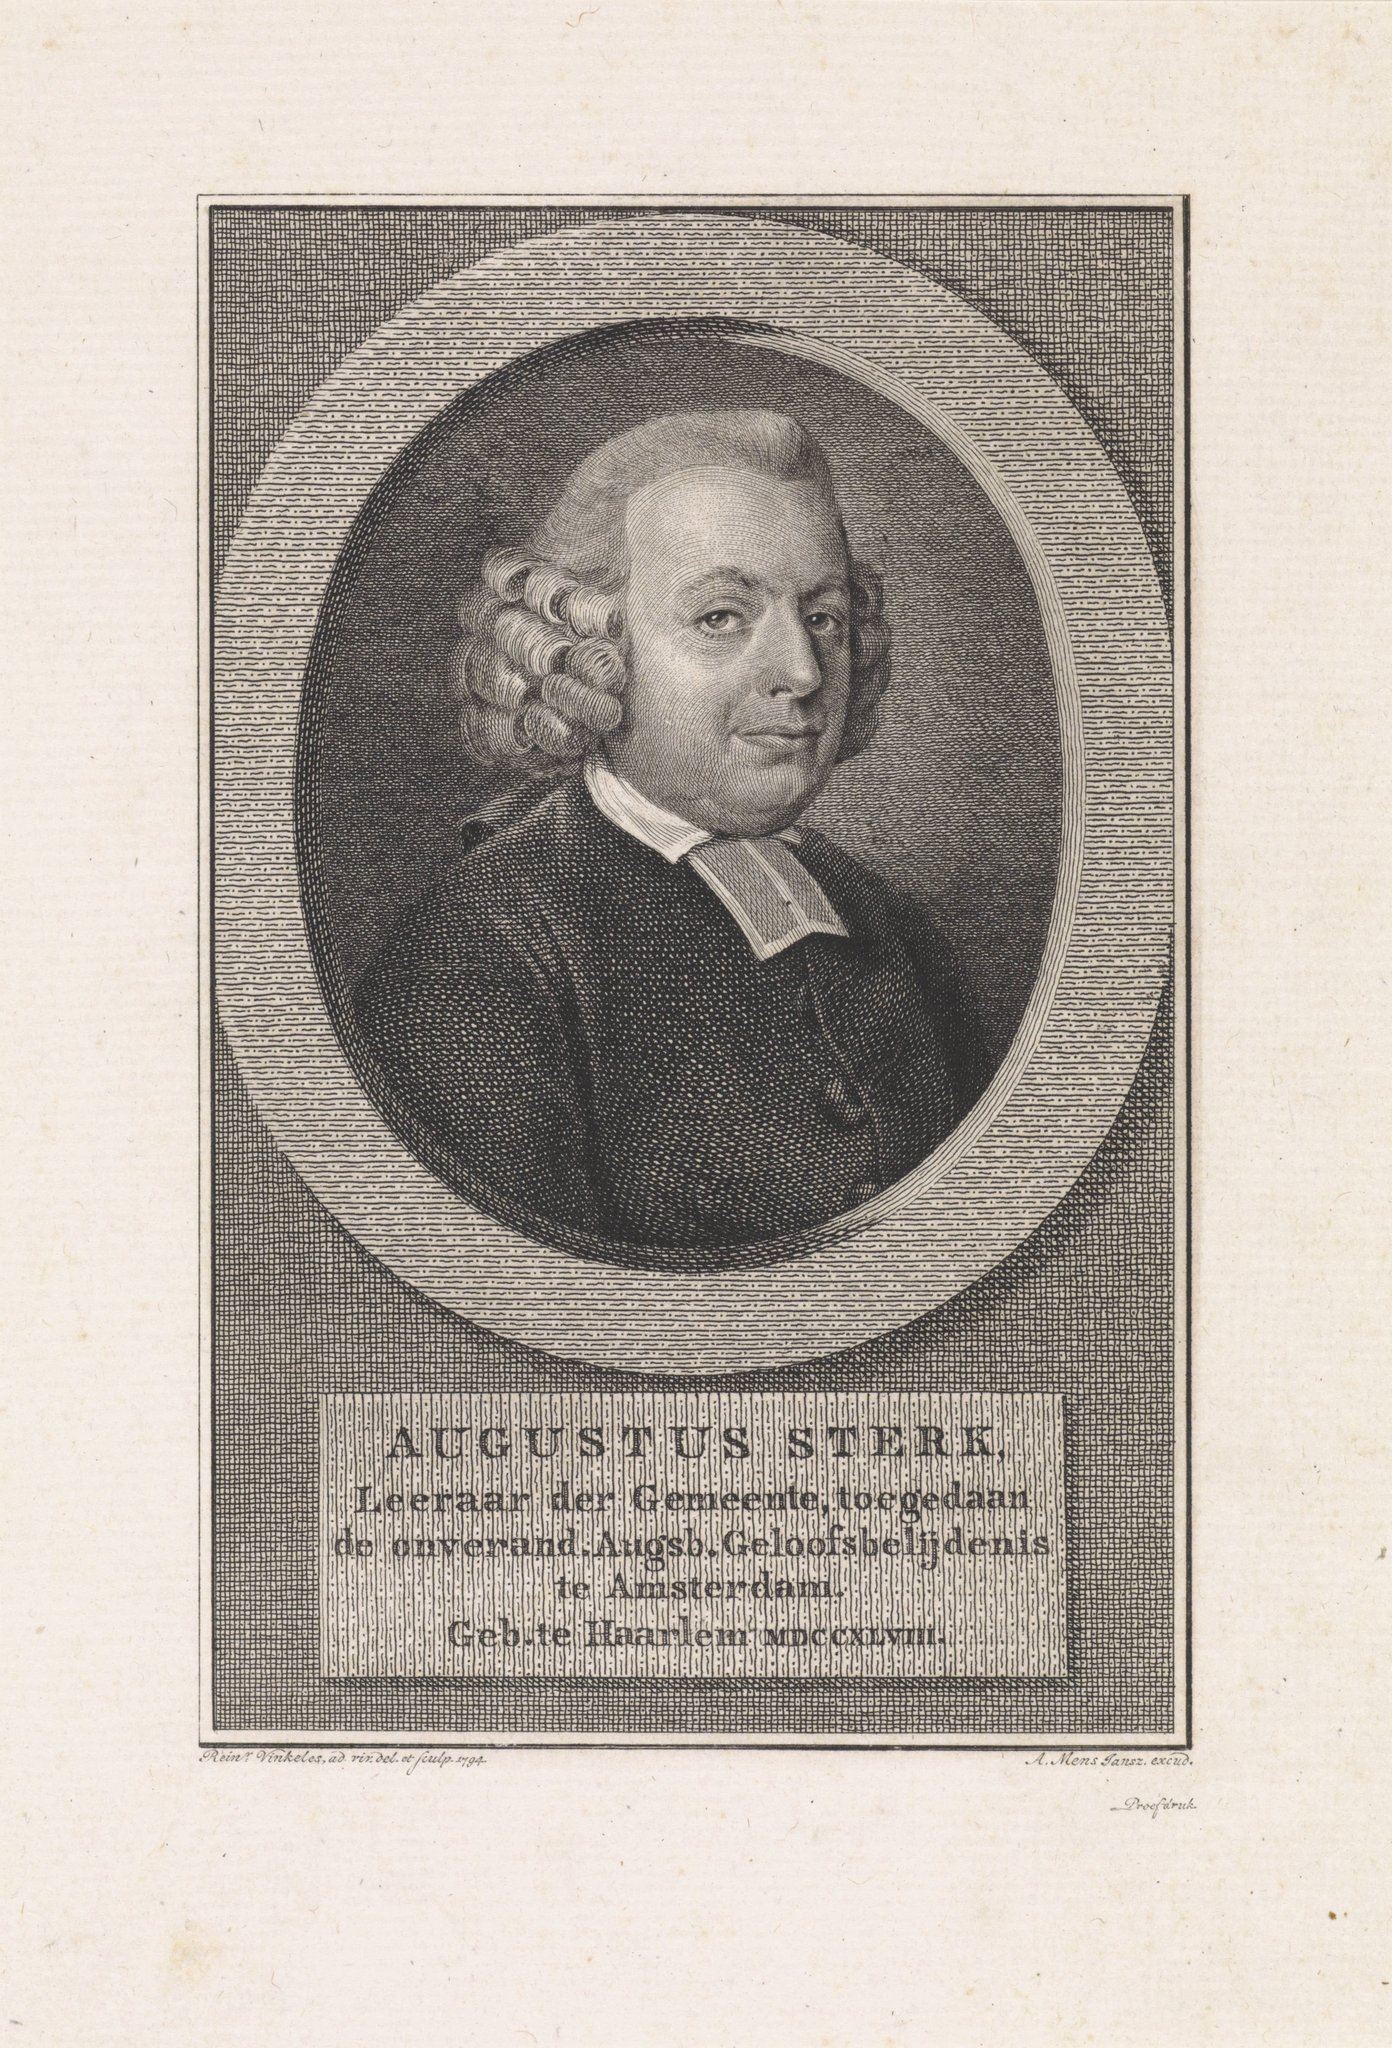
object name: print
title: Portret van Augustus Sterk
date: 1794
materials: paper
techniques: engraving, etching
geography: amsterdam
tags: haarlem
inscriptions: collector's mark: Lugt 2228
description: Portret van Augustus Sterk, Luthers predikant te Amsterdam.